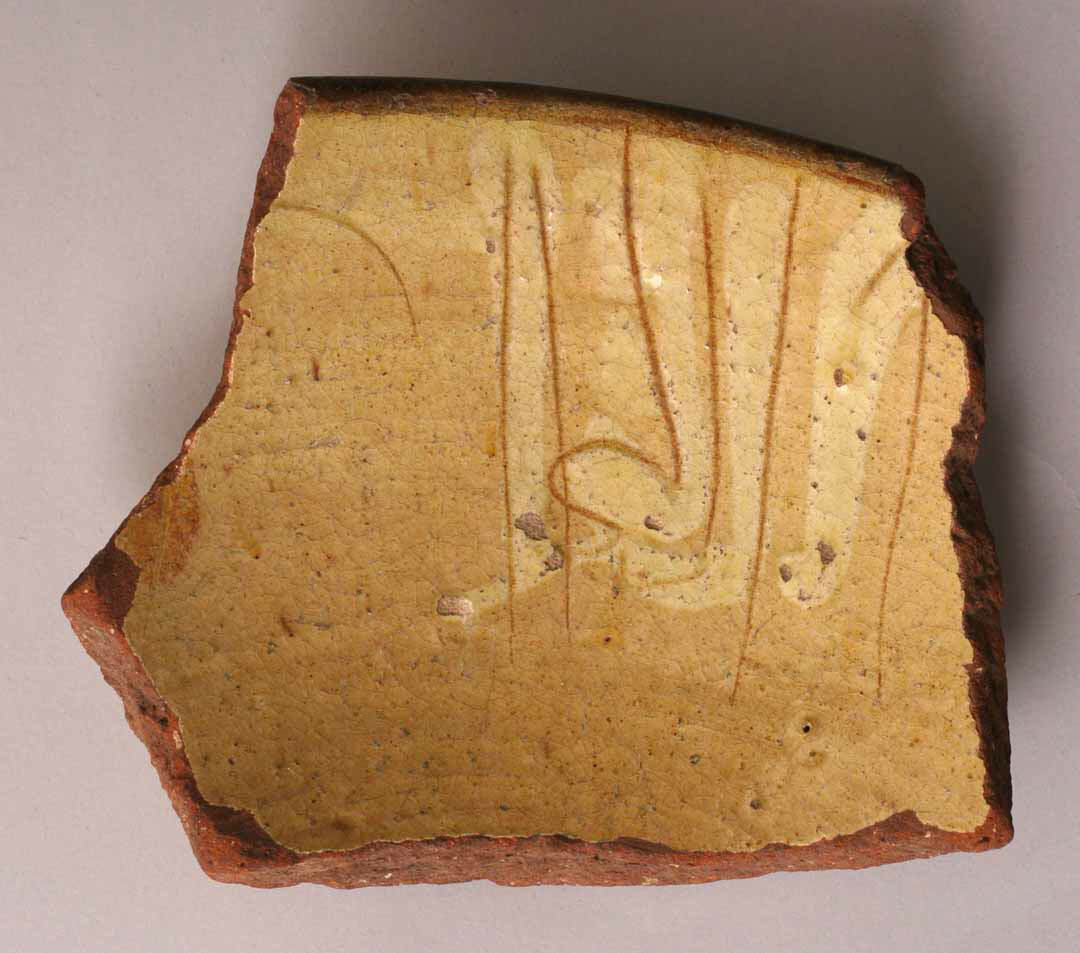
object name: ceramic fragment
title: Fragment of Bowl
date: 1301-1500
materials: earthenware, glaze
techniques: coloring, incising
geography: egypt